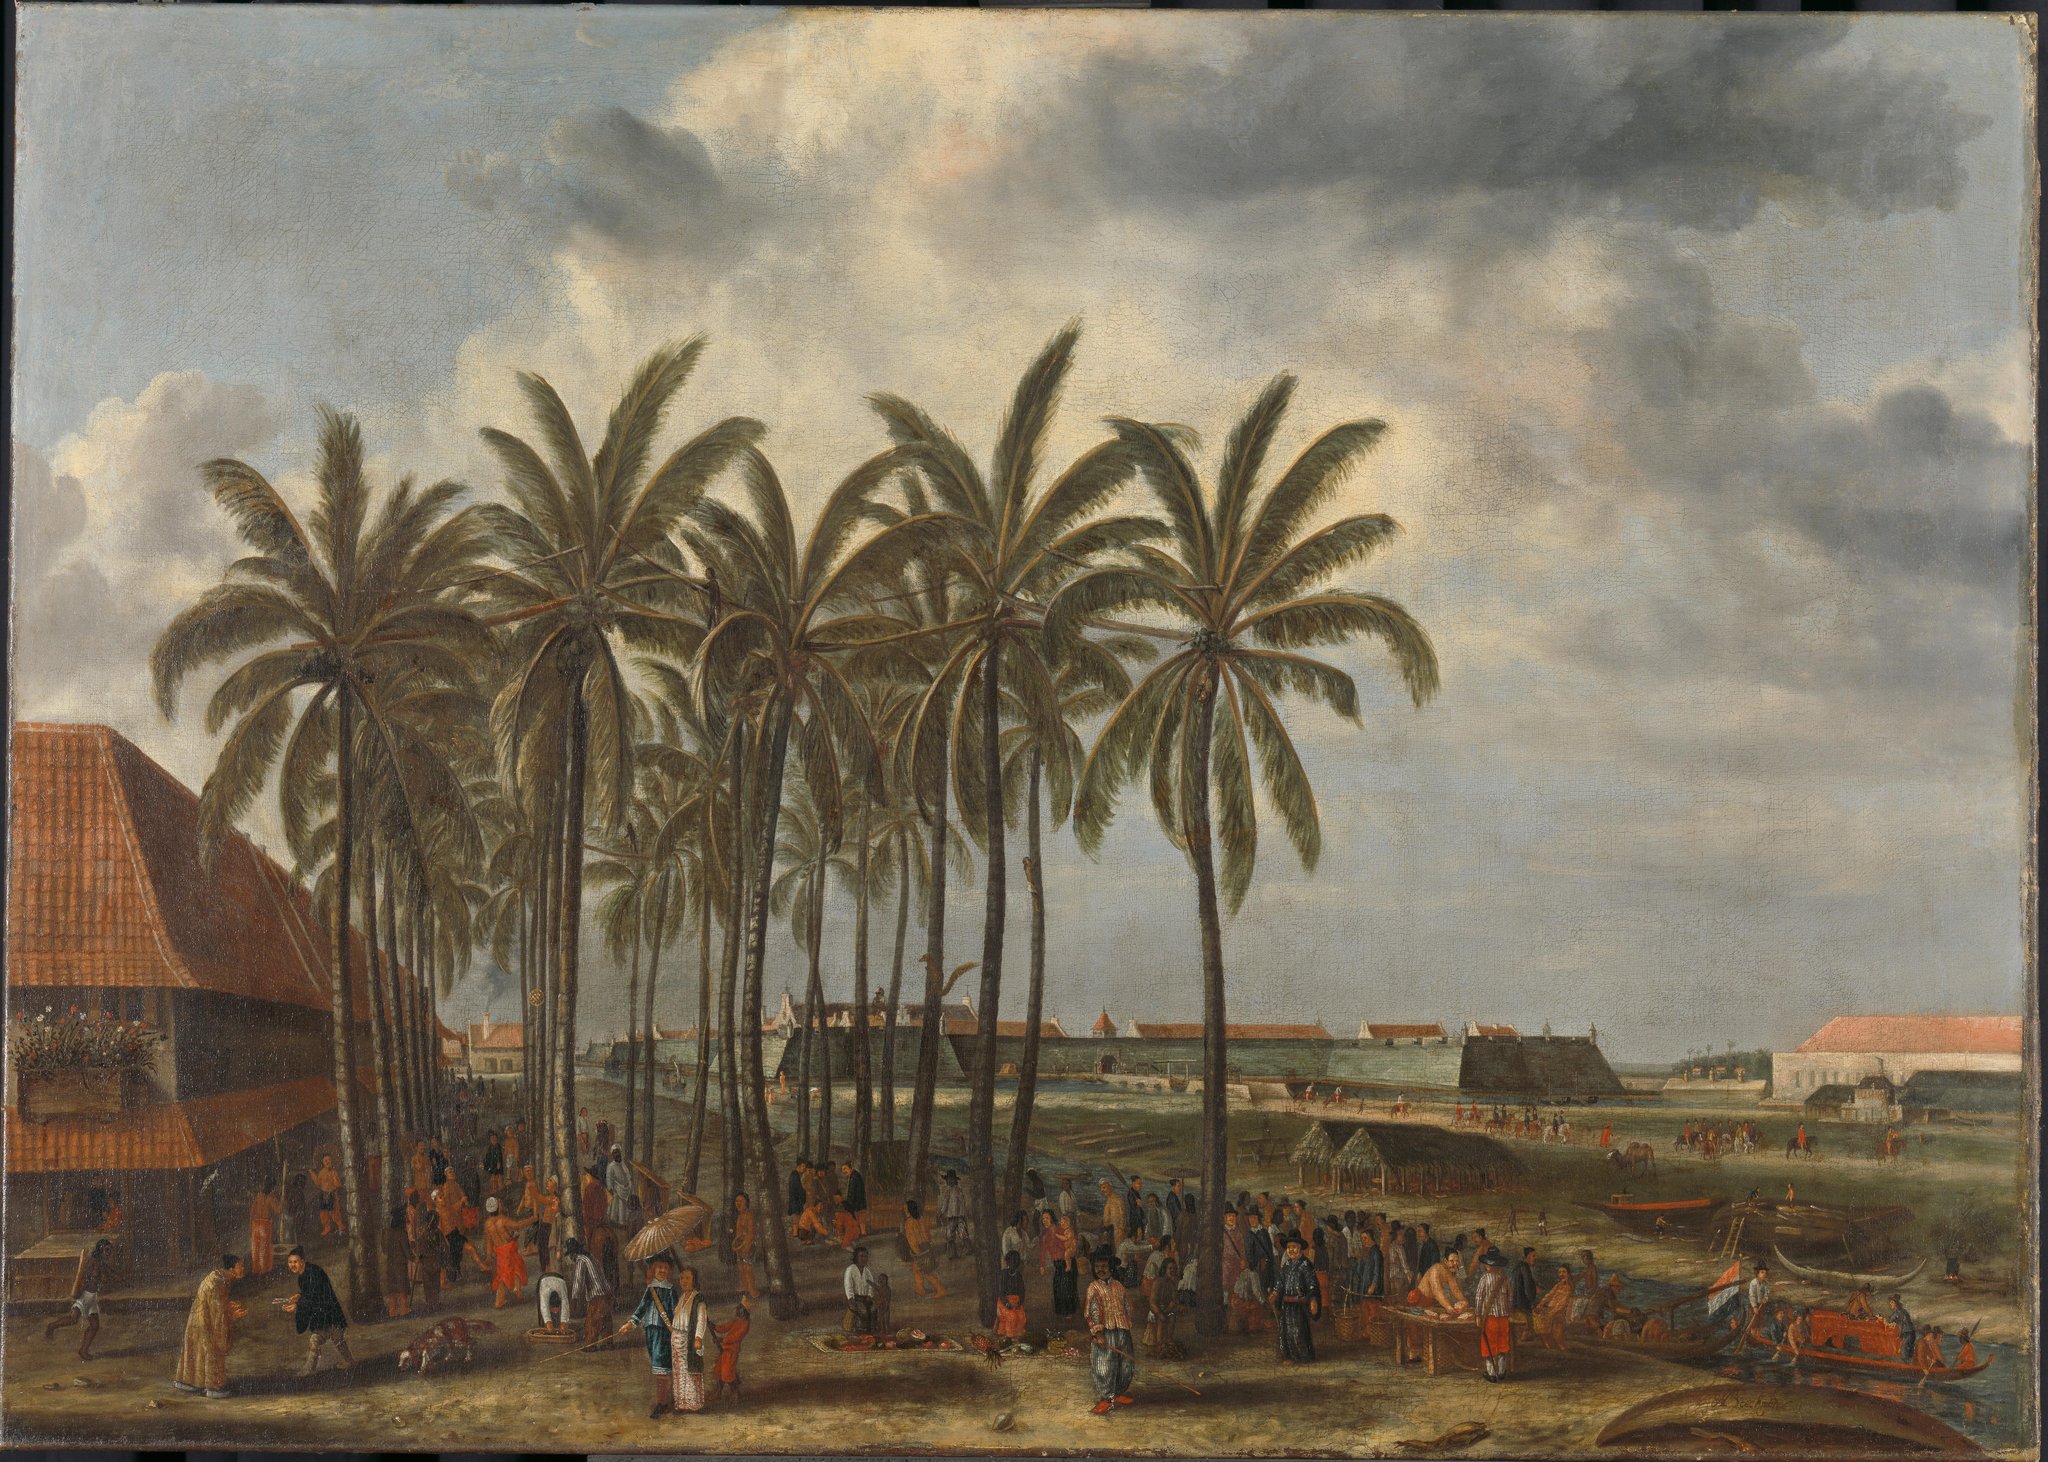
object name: painting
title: View of Batavia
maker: andries beeckman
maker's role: painter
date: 1662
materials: canvas, oil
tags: market, trees: palm-tree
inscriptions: signature, bottom right, on the upturned boat (A and B ligated): ‘ABeeckman F’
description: These people would never have all been together at the same time! Beeckman was trying to give an overview of the different ethnic groups in Batavia. They include Japanese, Indians, ‘mardijkers’ – formerly enslaved people, recognizable by their striped clothing – and a Dutch-Eurasian couple and their enslaved servant with a pajong (sunshade). A Javanese woman sells fruit, a Chinese person is fishing and Moluccans play football with a rattan ball. This painting hung in the assembly room of the Dutch East India Company (VOC) headquarters in Amsterdam.